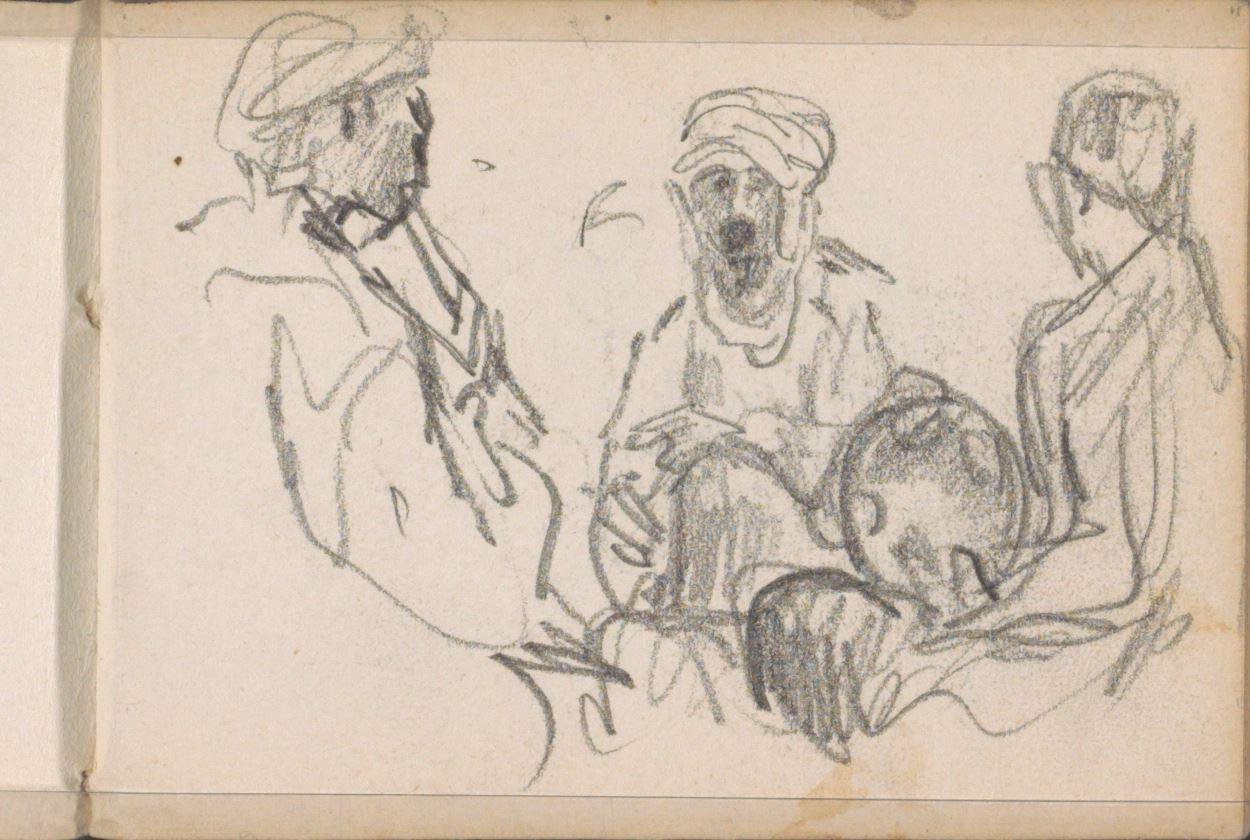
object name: sketchbook leaf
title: Drie Algerijnen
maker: marius bauer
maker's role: draughtsman, print maker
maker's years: 1867-1932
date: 1922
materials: paper, pencil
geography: biskra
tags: head-gear (with name), africans, folk costume, regional costume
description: De mannen dragen traditioneel Noord-Afrikaans kostuum. Pagina 11 uit een schetsboek met 32 bladen.